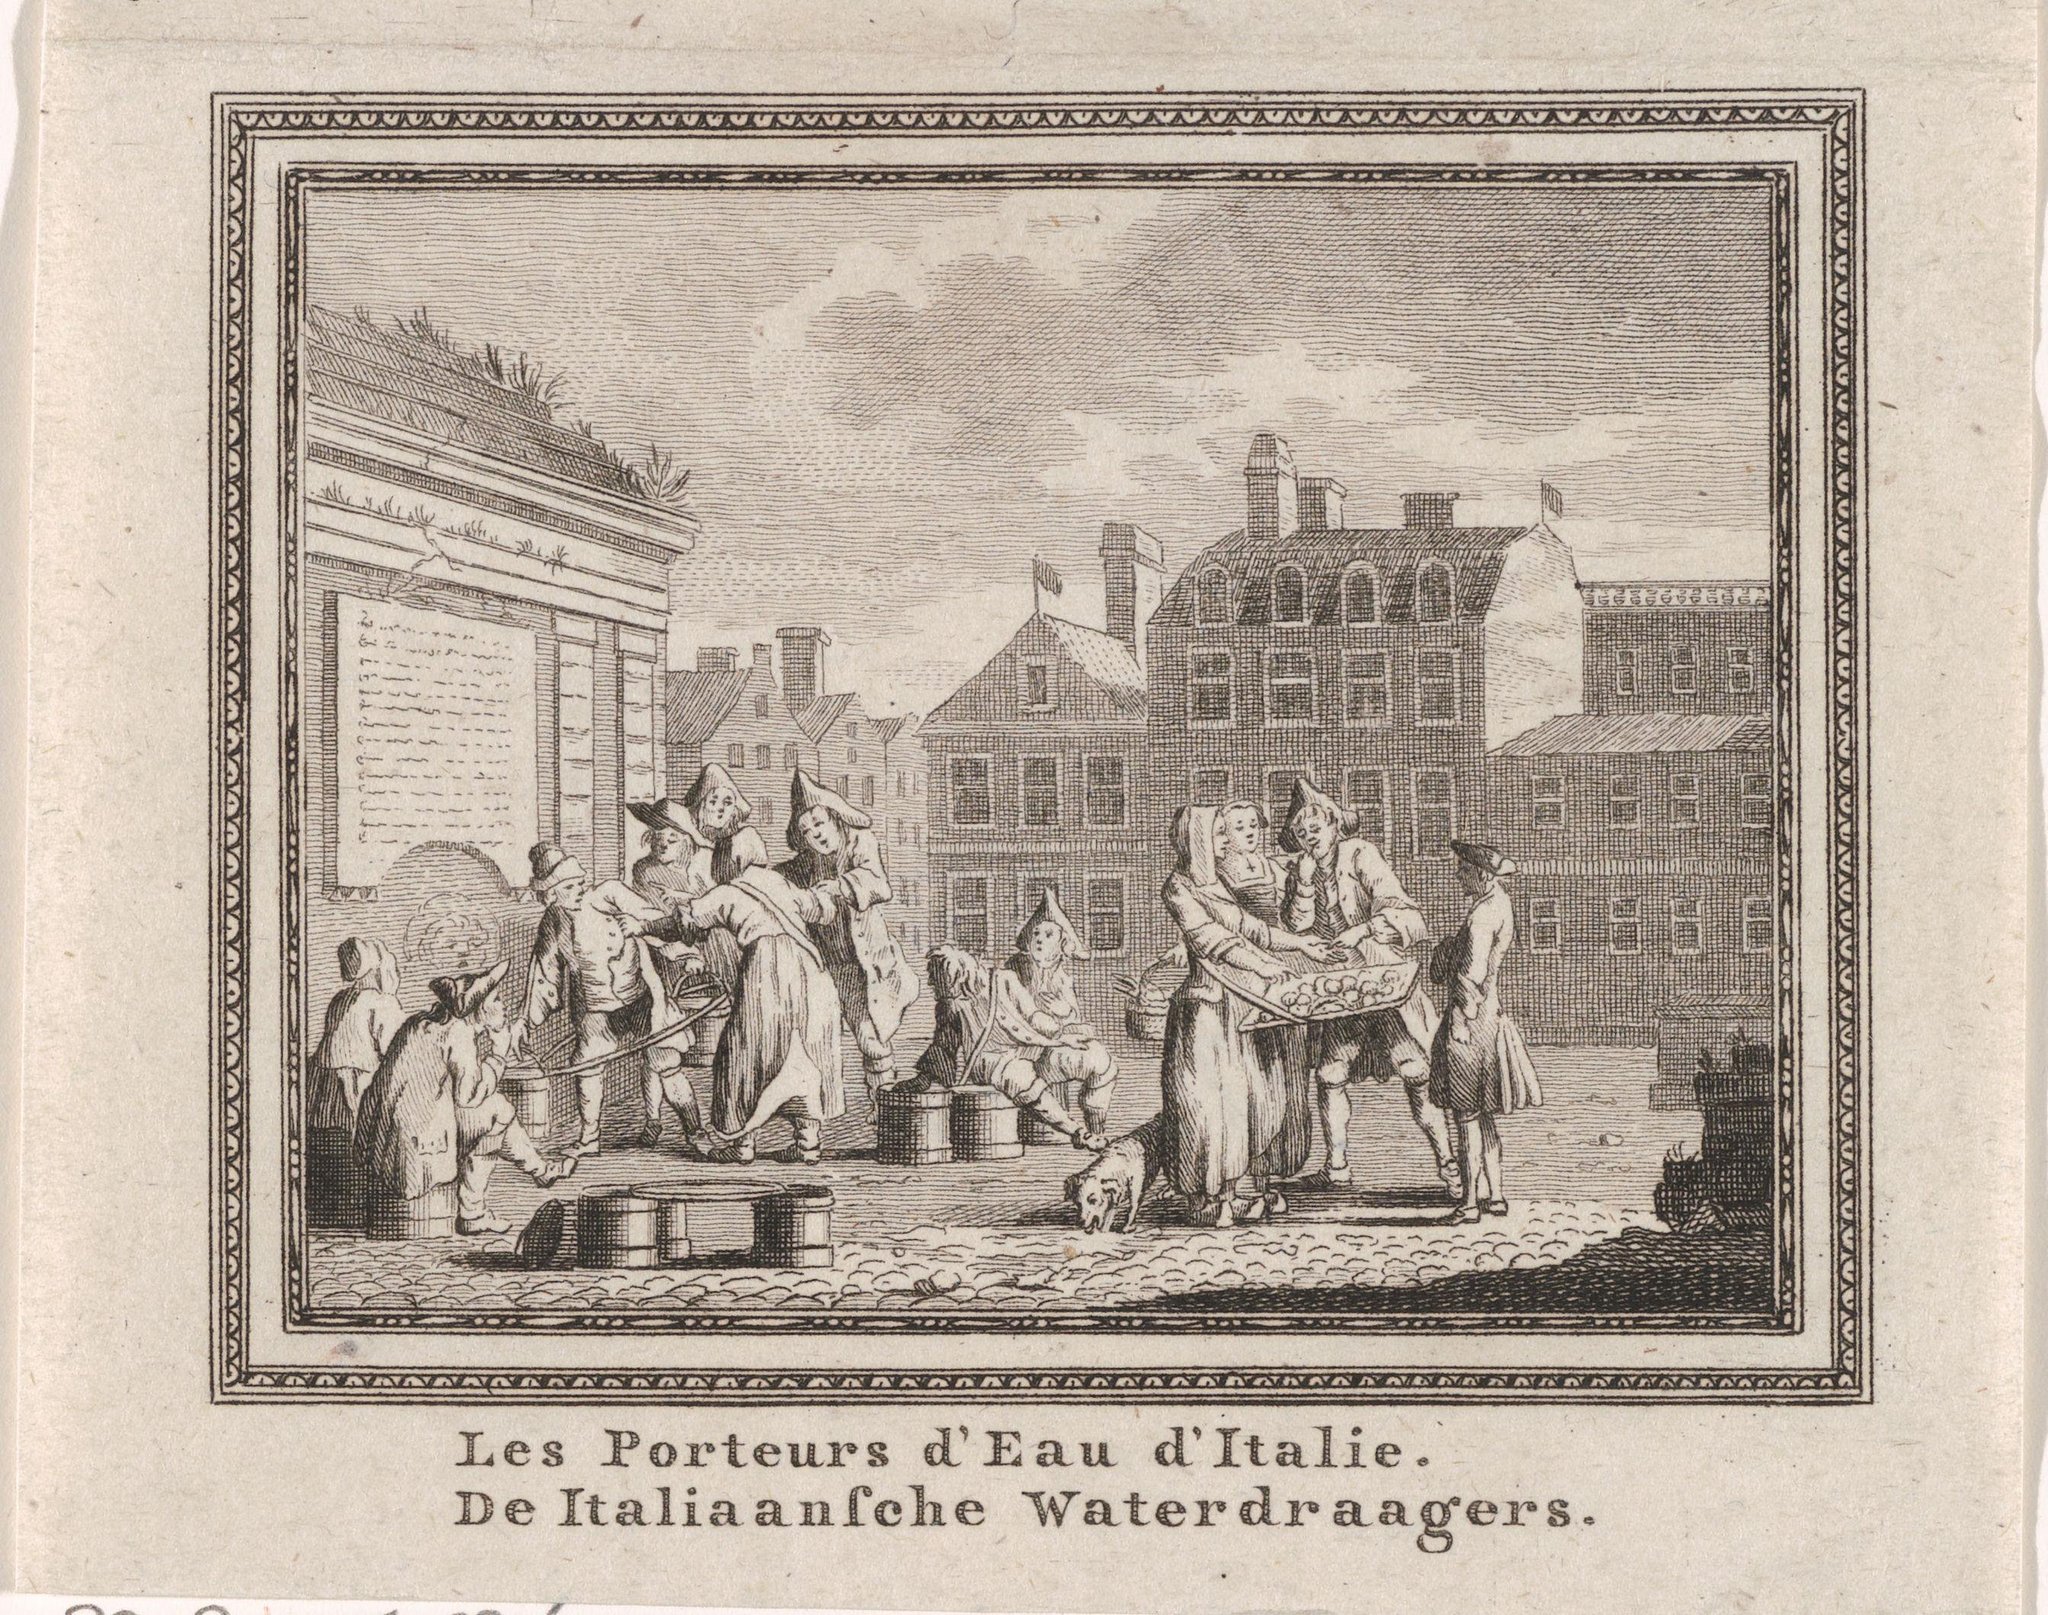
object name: print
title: Italiaanse waterdragers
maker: Anonymous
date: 1750-1850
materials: paper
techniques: etching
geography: netherlands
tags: carrying something on the head or on the shoulders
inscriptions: collector's mark: Lugt 2228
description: Waterdragers bij een fontein op een plein.